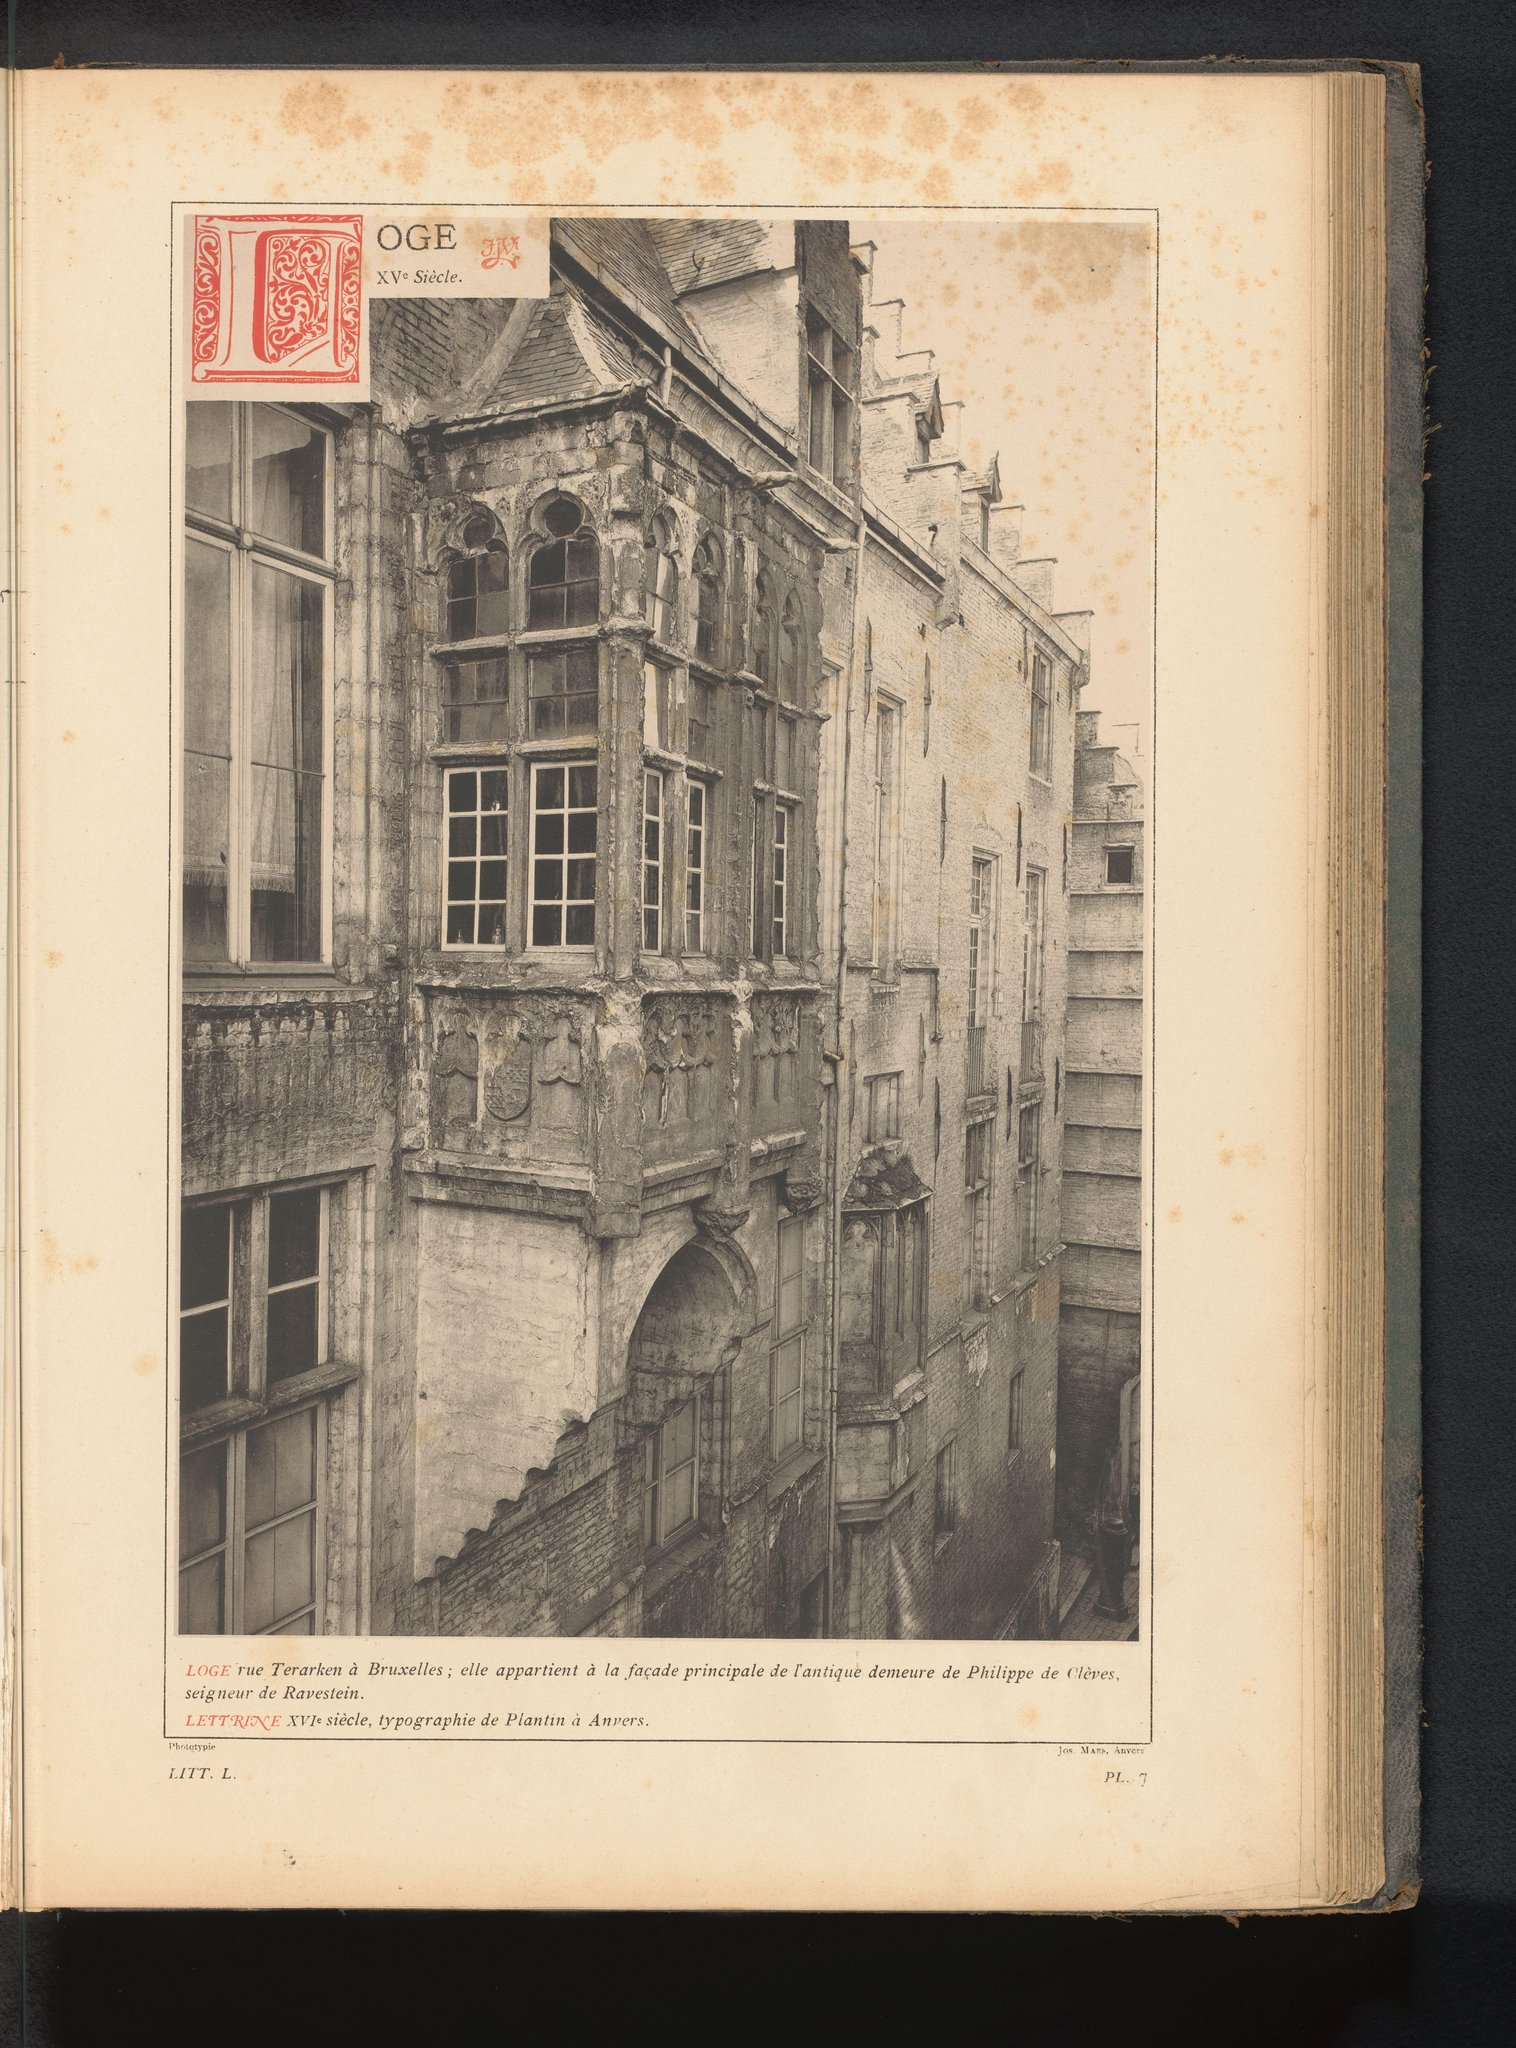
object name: photomechanical print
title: Loge, XVe Siècle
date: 1875-1880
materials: paper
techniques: photograph, photolithography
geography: brussels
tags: hotel, hostelry, inn, brussels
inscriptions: inscription: ‘LITT. L. - PL. 7’, monogram: ‘JJvY’, inscription: ‘LOGE rue Terarken (...)’